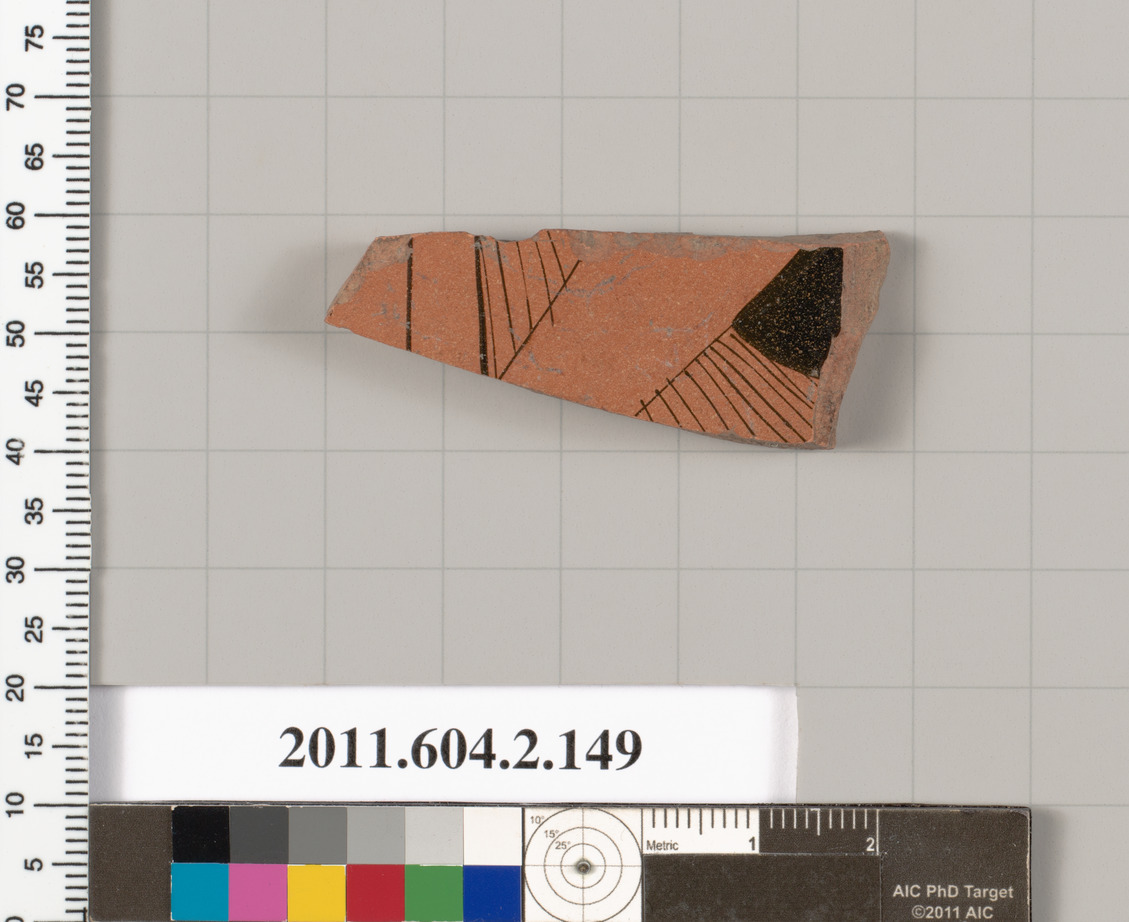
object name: stamnos fragment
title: Terracotta fragment of a stamnos (jar)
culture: greek, attic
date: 470-460 BCE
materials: terracotta